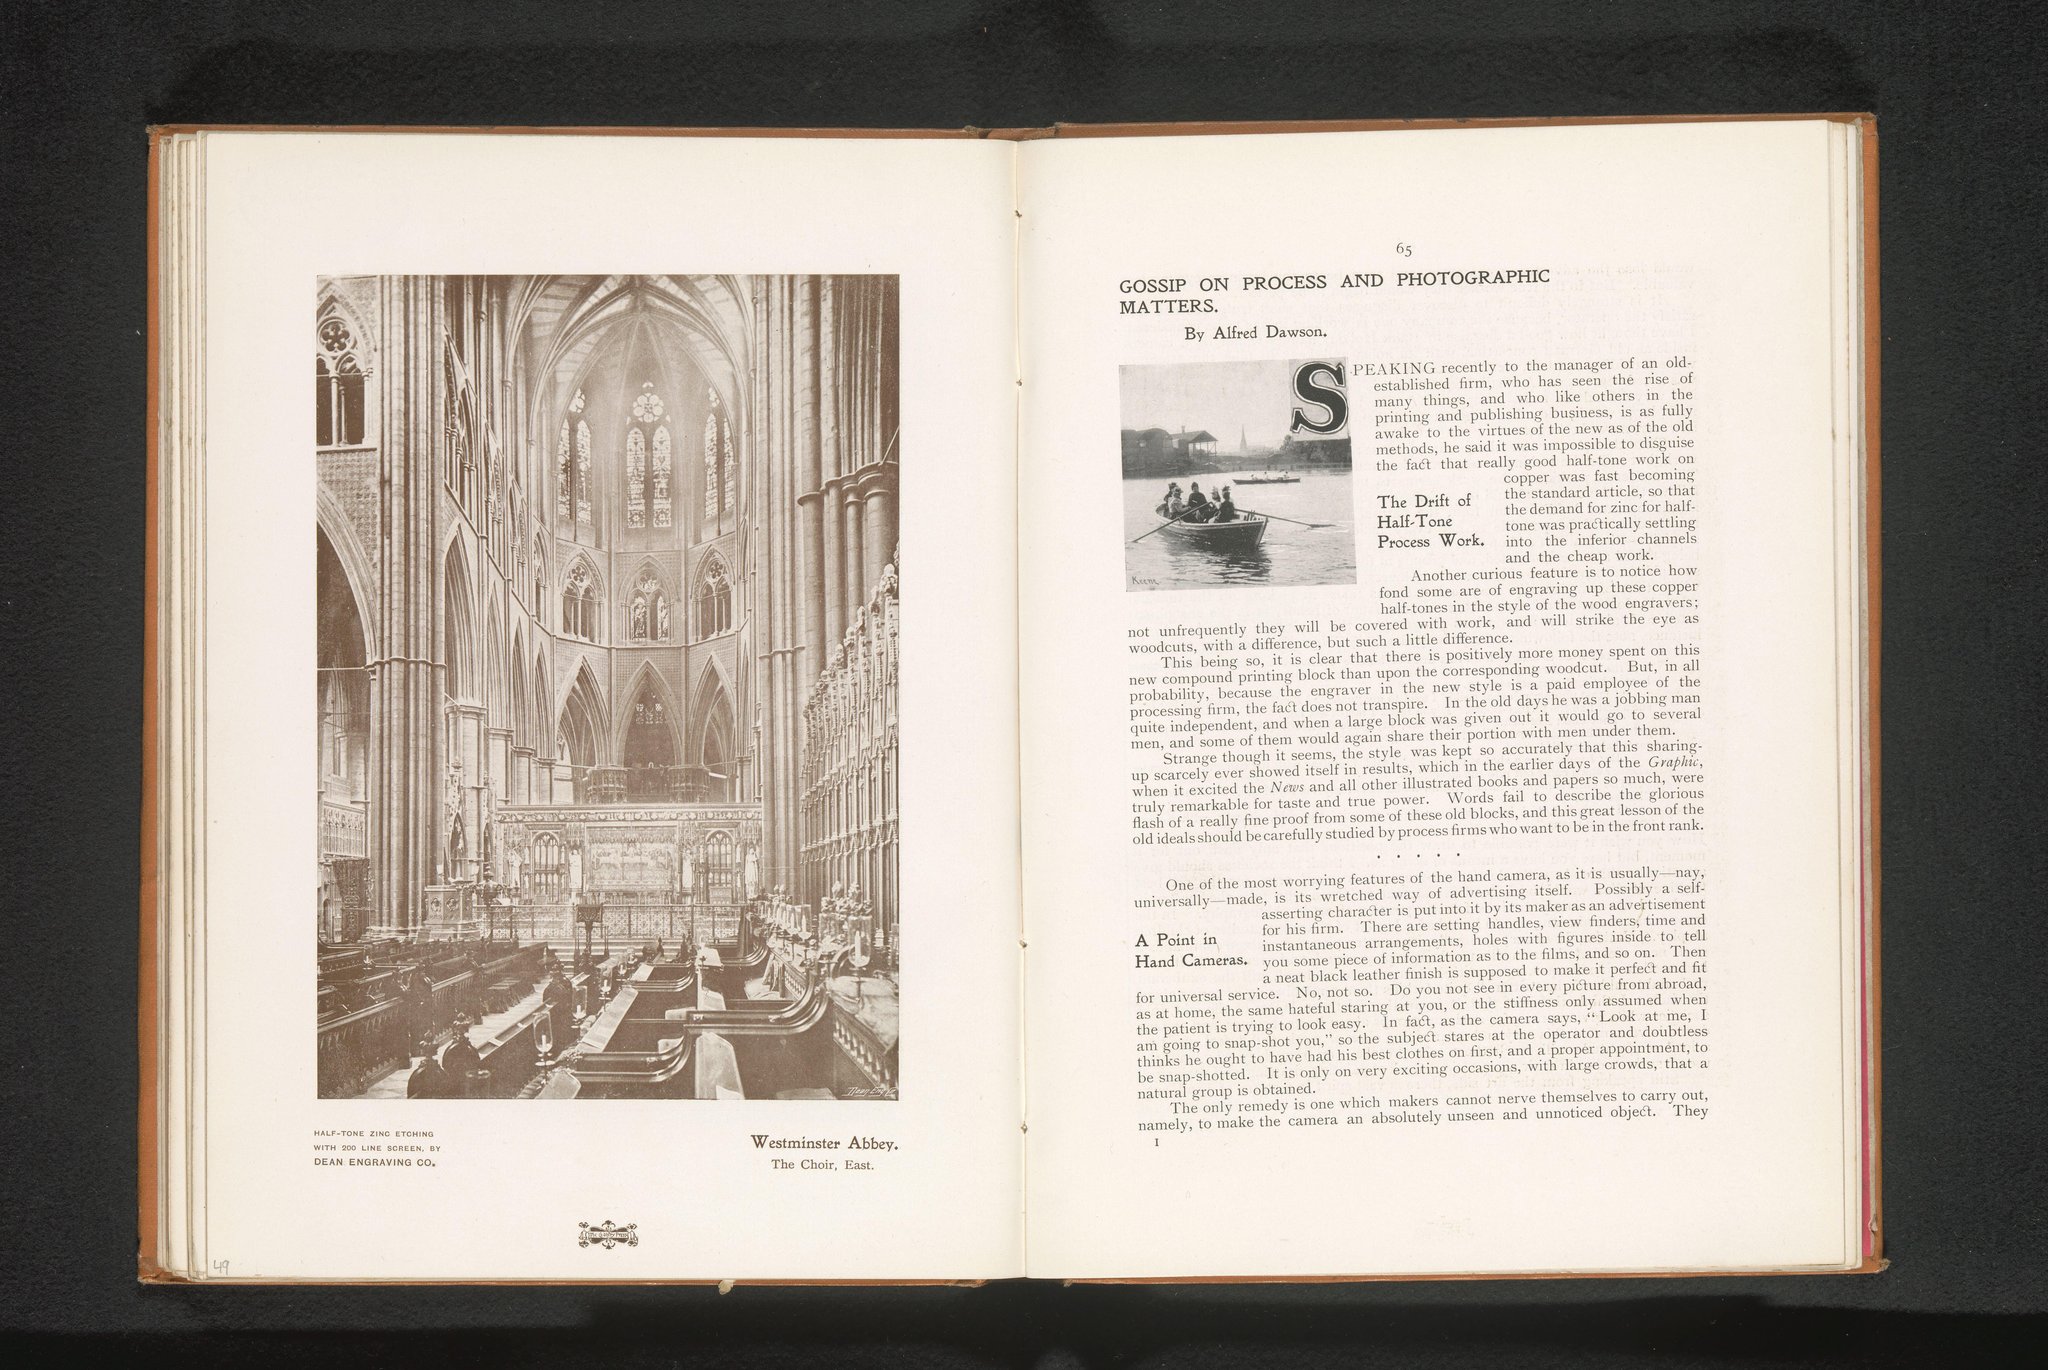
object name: photomechanical print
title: Westminster Abbey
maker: Anonymous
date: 1894-1899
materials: paper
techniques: autotype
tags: parts of church interior: choir, westminster abbey